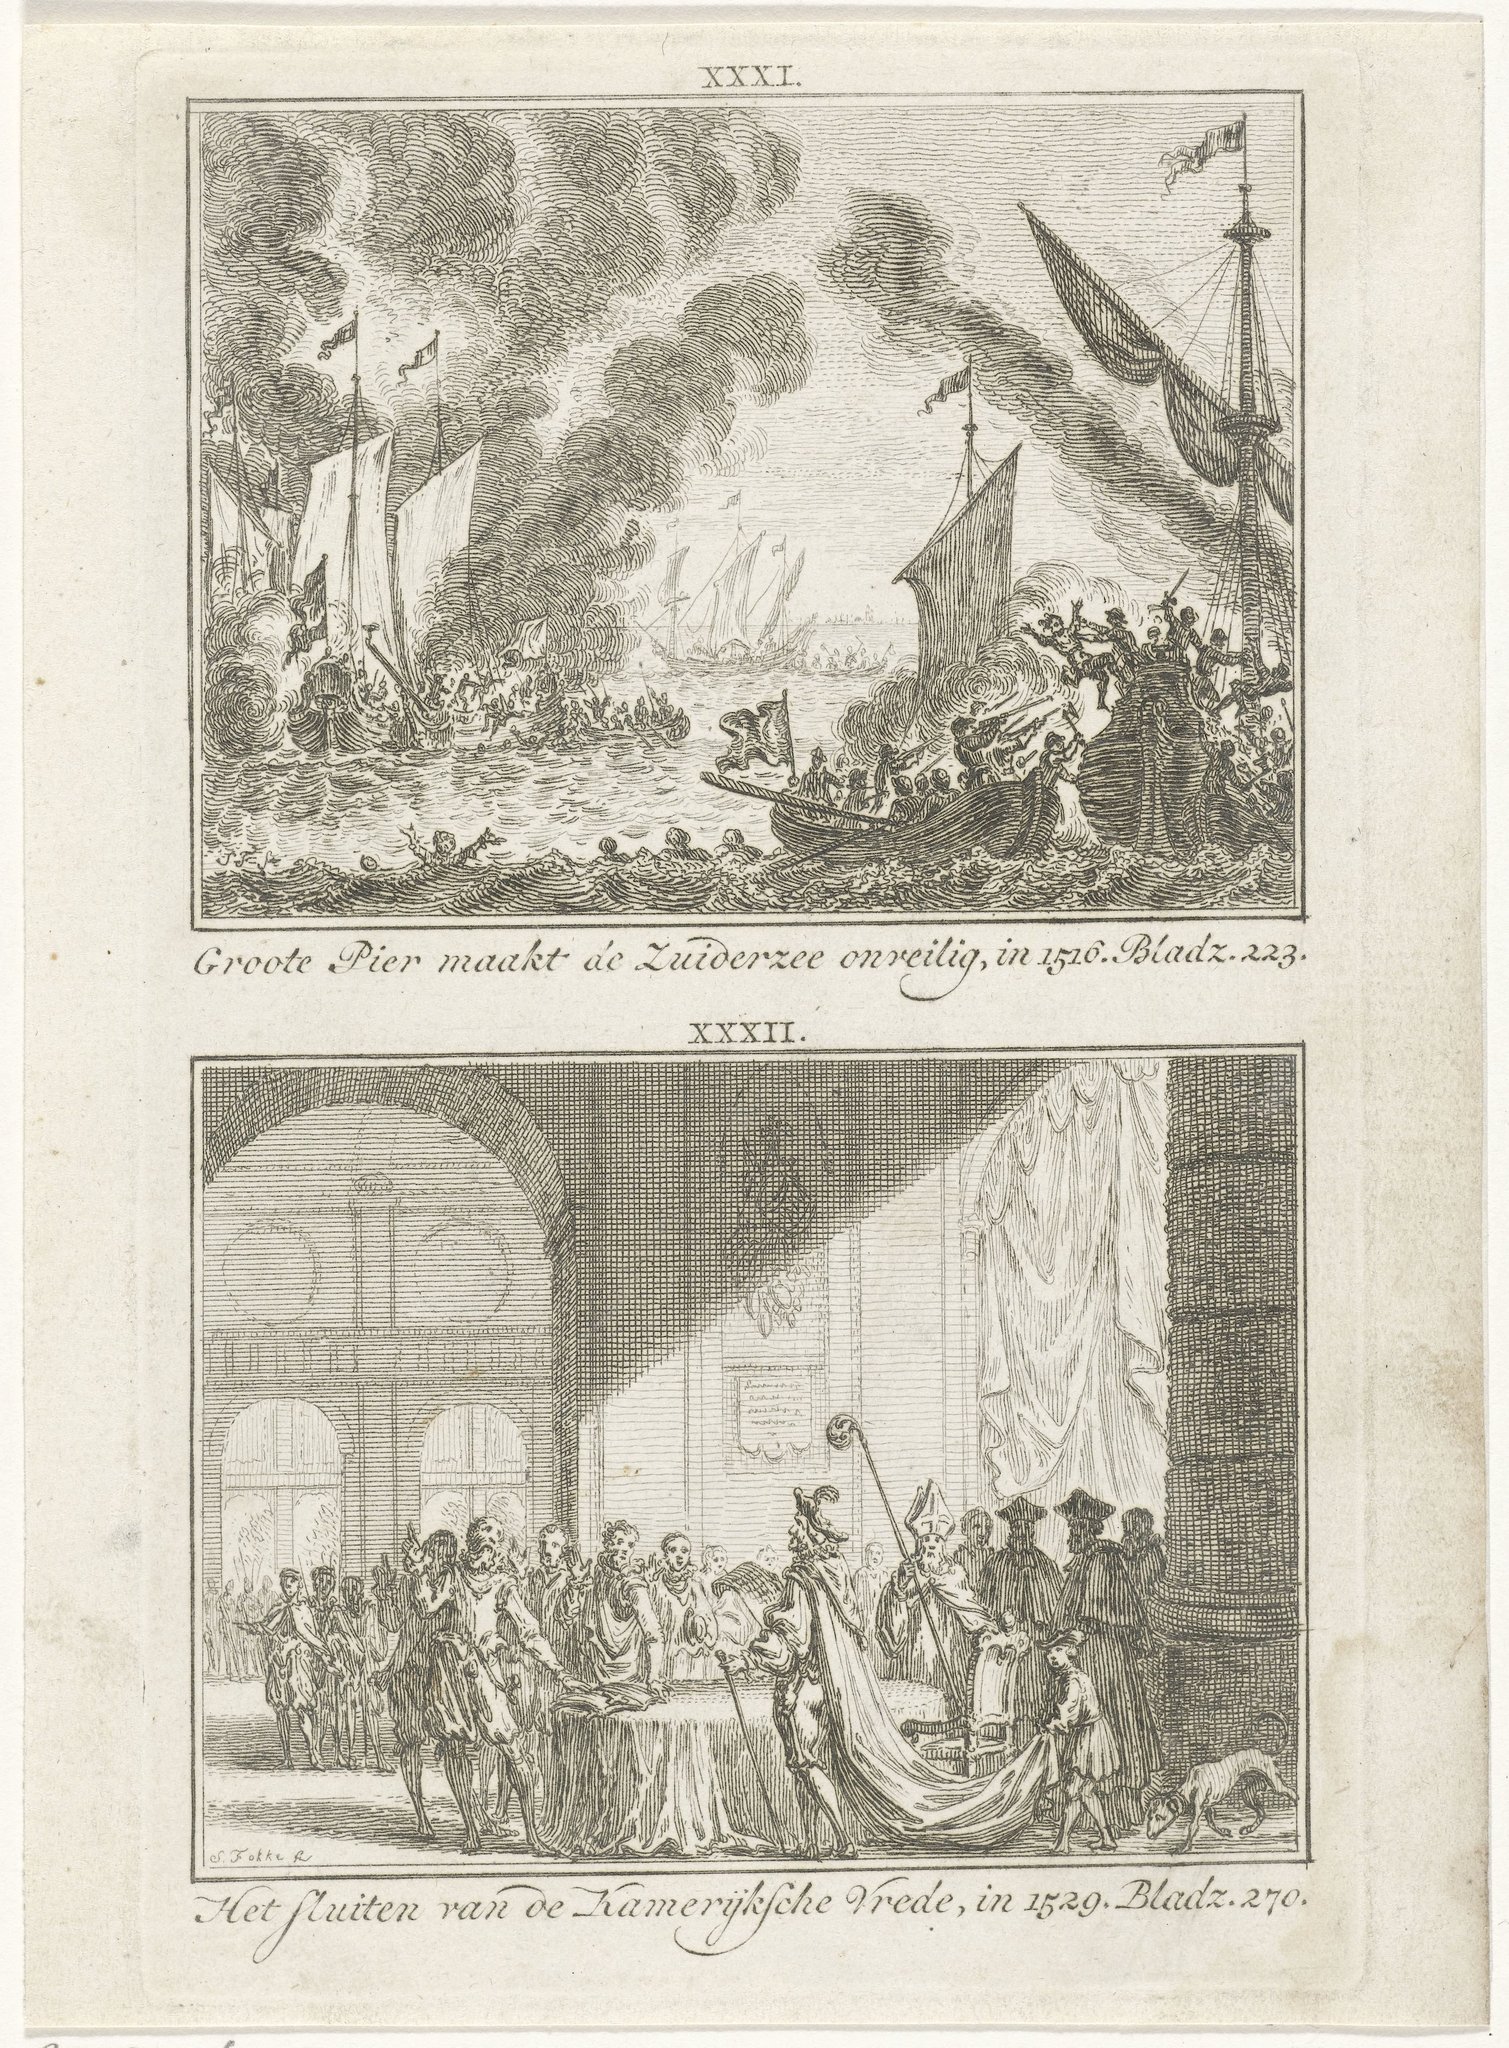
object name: book illustration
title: Grote Pier maakt de Zuiderzee onveilig, 1516, en Vrede van Kamerijk, 1529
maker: simon fokke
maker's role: draughtsman, print maker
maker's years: 1712-1784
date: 1784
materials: paper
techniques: etching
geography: amsterdam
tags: frans i van valois-angoulême (koning van frankrijk), ghent, charles v (holy roman emperor and king of spain), signing of peace treaty, concluding the peace, piracy, zuiderzee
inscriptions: collector's mark: Lugt 2228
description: Voorstellingen uit de vaderlandse geschiedenis. Boven: Grote Pier maakt met zijn piraterij de Zuiderzee onveilig, 1516. Onder: Het sluiten van de Vrede van Kamerijk op 5 augustus 1529 tussen keizer Karel V en de Franse koning Frans I. De twee vorsten leggen de eed af. Twee voorstellingen van één plaat, respectievelijk genummerd: XXXI en XXXII.